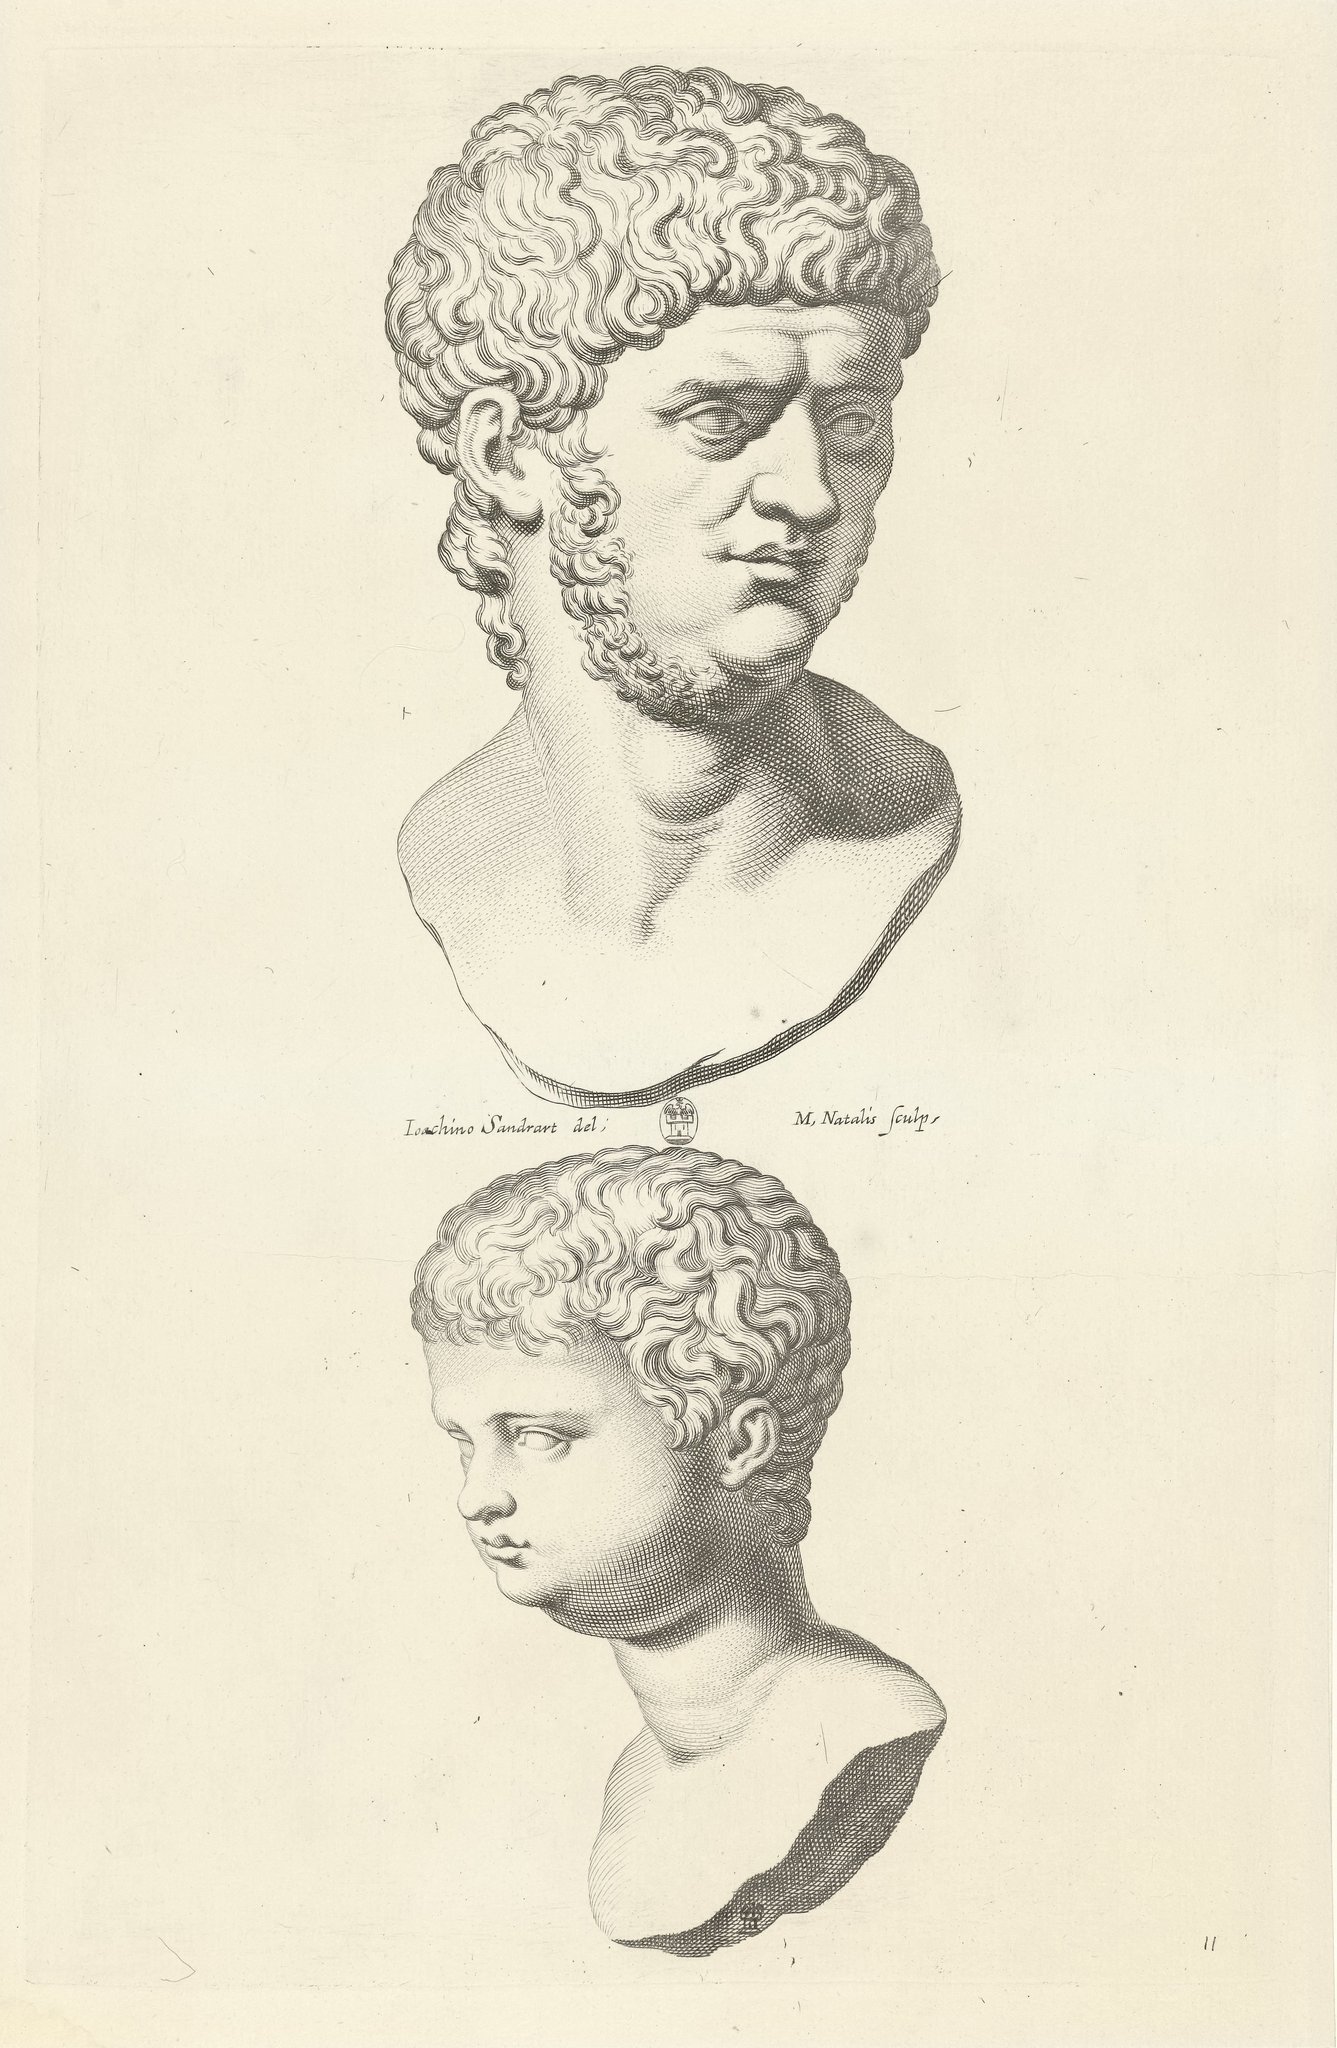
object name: print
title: Galleria Giustiniana del Marchese Vincenzo Giustiniani II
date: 1640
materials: paper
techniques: engraving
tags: male persons from classical history (+ head (and shoulders)), piece of sculpture, reproduction of a piece of sculpture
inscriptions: collector's mark: Lugt 2228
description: Twee Romeinse sculpturen. Boven het portret van Romeins keizer Nero, het hoofd naar rechts gewend. Daaronder het wapenschild van Vincenzo Giustiniani. Onder het hoofd van de jonge Nero, naar links. Prent uit een serie naar de sculpturen in de verzameling in de Galleria Giustiniani te Rome.